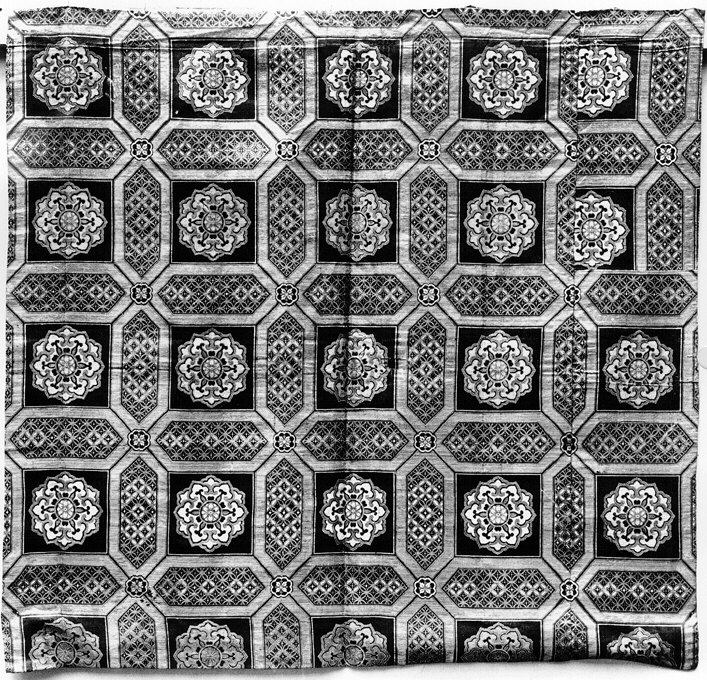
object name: altar cloth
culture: japanese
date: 1673-1681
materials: silk